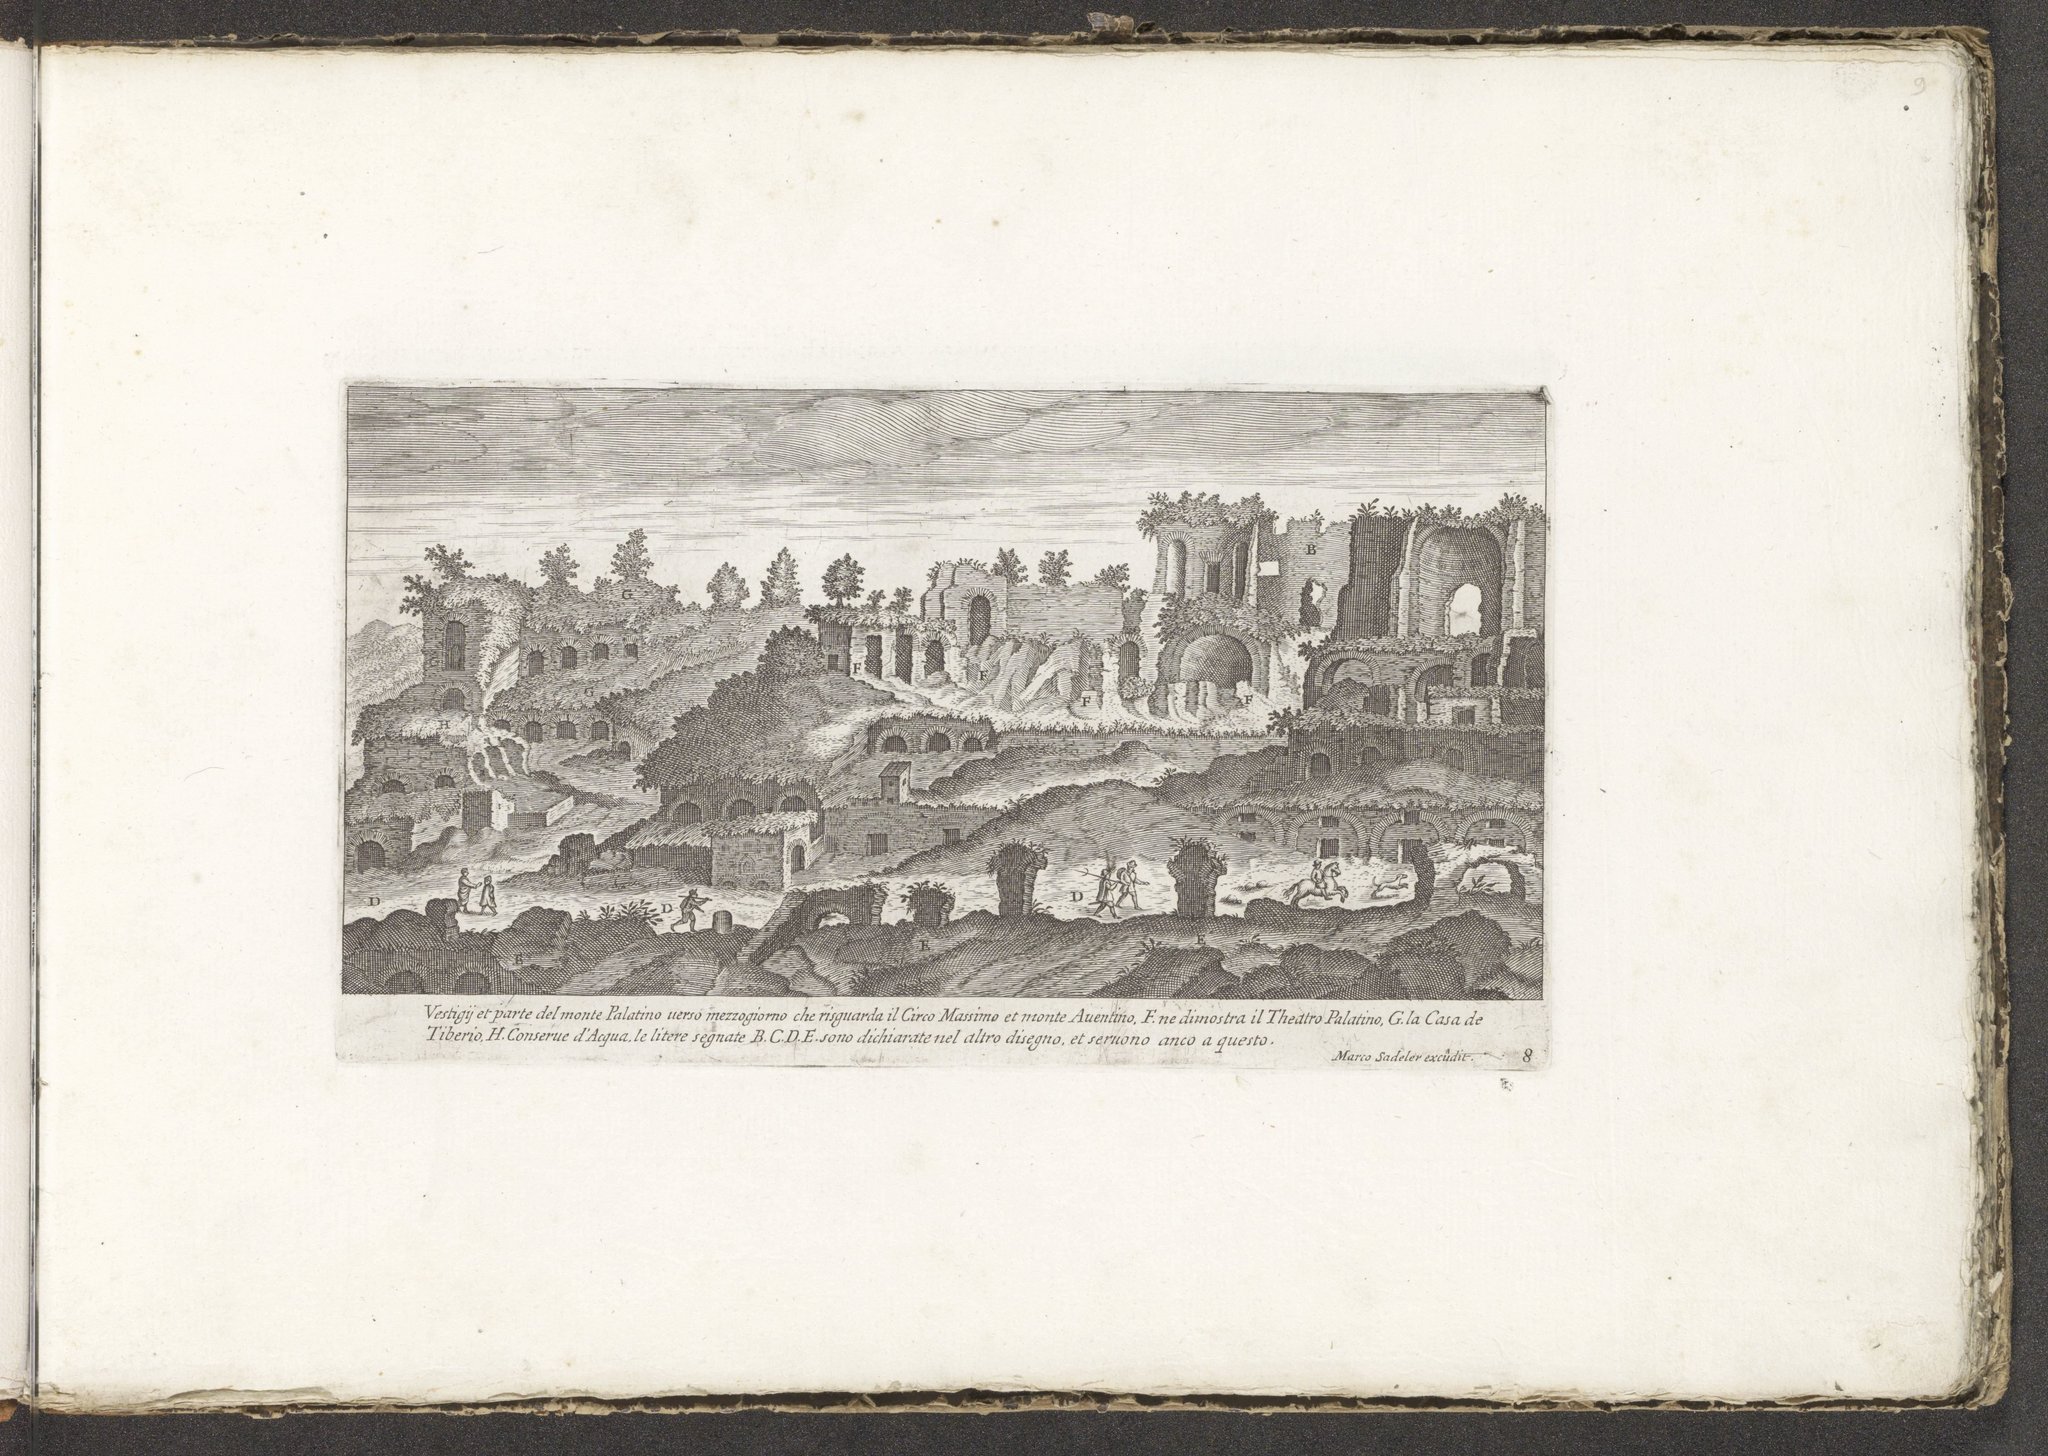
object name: album leaf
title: Vestigi delle antichita di Roma, Tivoli, Pozzuolo et altri luochi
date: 1680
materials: paper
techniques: engraving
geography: prague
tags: palatijn, casa di tiberio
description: Ruïnes op de hellingen van de Palatijn. Links de Casa di Tiberio. Figuren op de voorgrond. Rechts een man op een paard en een hond. In de ondermarge twee regels tekst in het Italiaans. De prent maakt deel uit van een album.